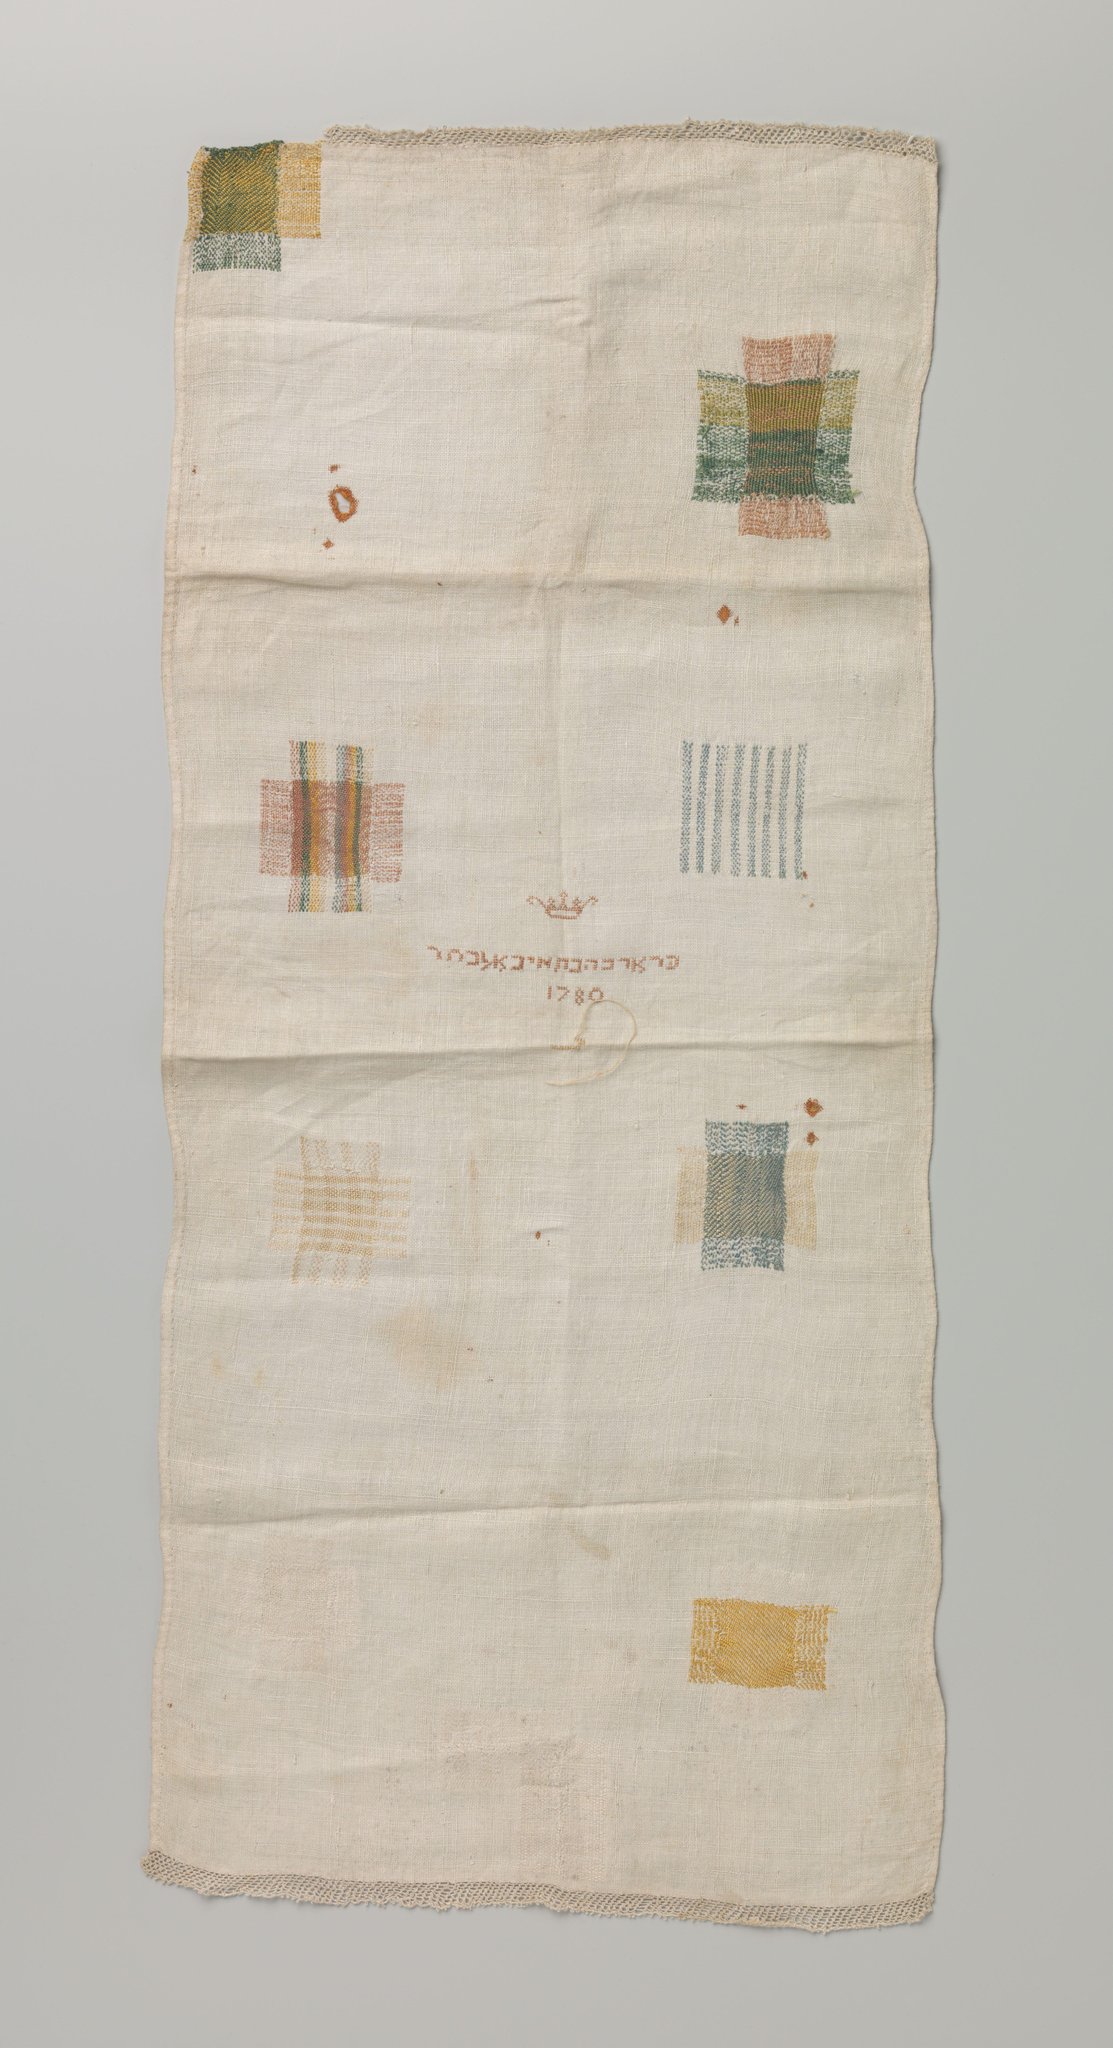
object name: stoplap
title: Stoplap met Hebreeuwse tekst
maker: Anonymous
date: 1780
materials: lace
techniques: embroidered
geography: netherlands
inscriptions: date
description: Stoplap met een Hebreeuwse tekst onder een kroon, het jaartal 1780 en diverse stoppen. De lap is afgezet met een strook naaldkant.